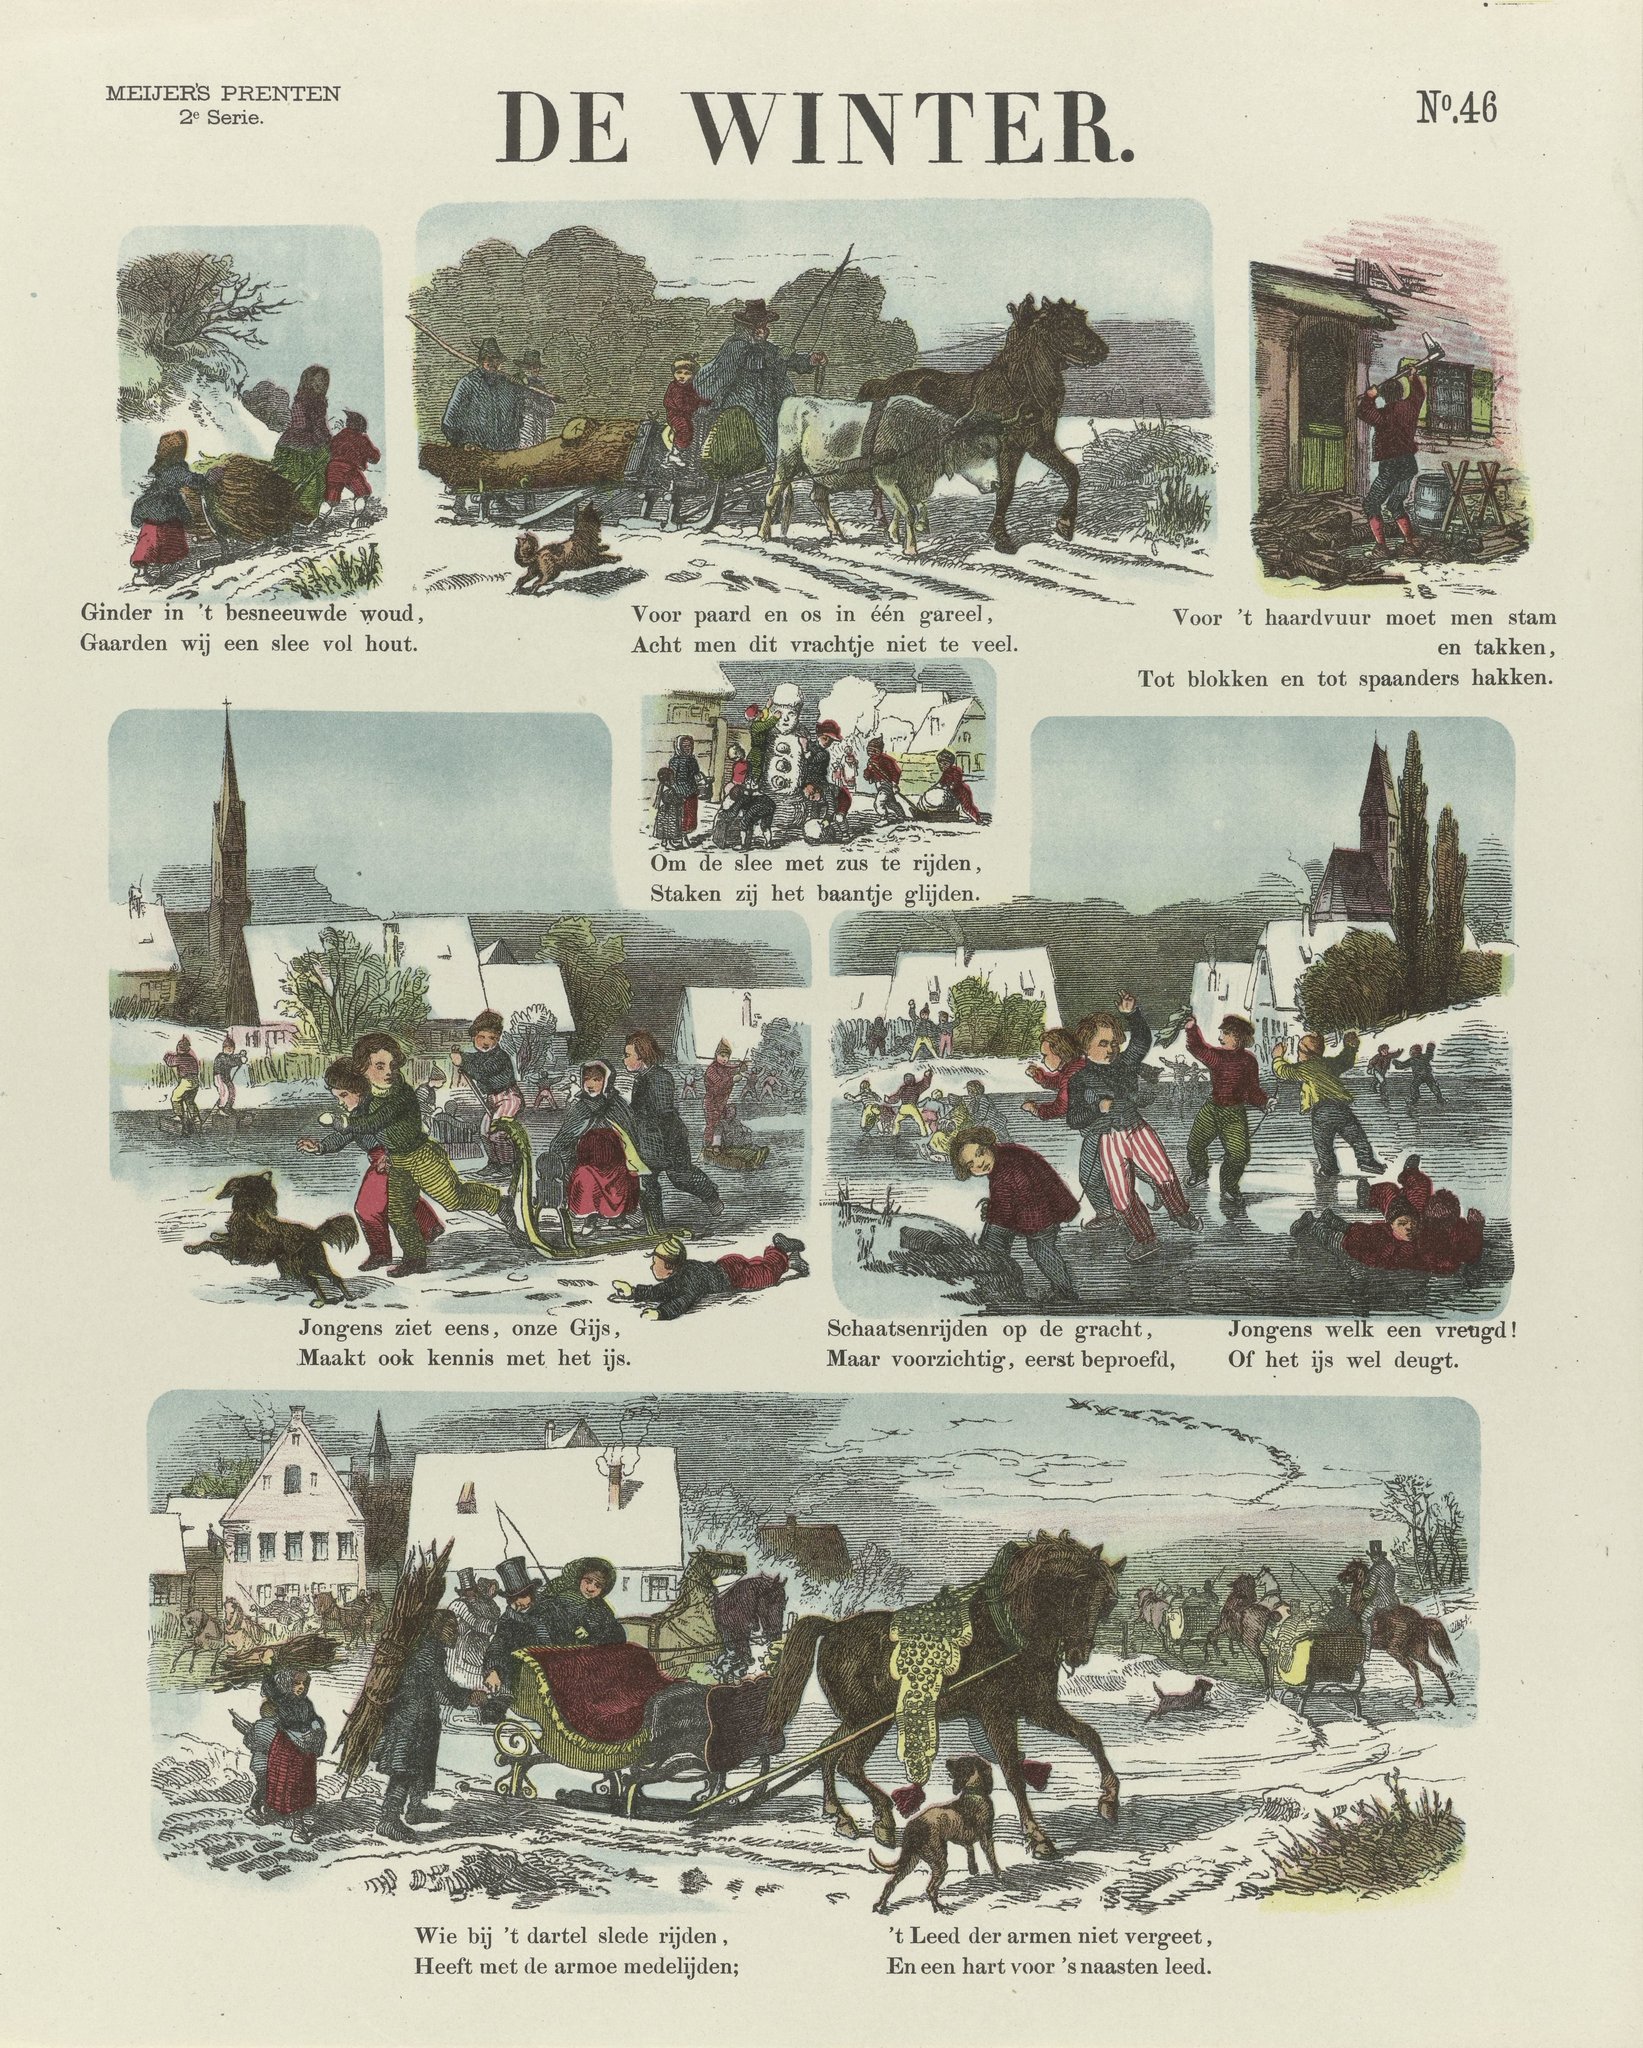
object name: print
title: De winter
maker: Anonymous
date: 1874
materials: paper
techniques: lithograph, letterpress printing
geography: amsterdam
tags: winter sports, skates (winter sports), sledge, sleigh (winter sports)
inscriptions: collector's mark: Lugt 2760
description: Blad met 7 wintertaferelen. Onder elke afbeelding een vers. Genummerd rechtsboven: No. 46.